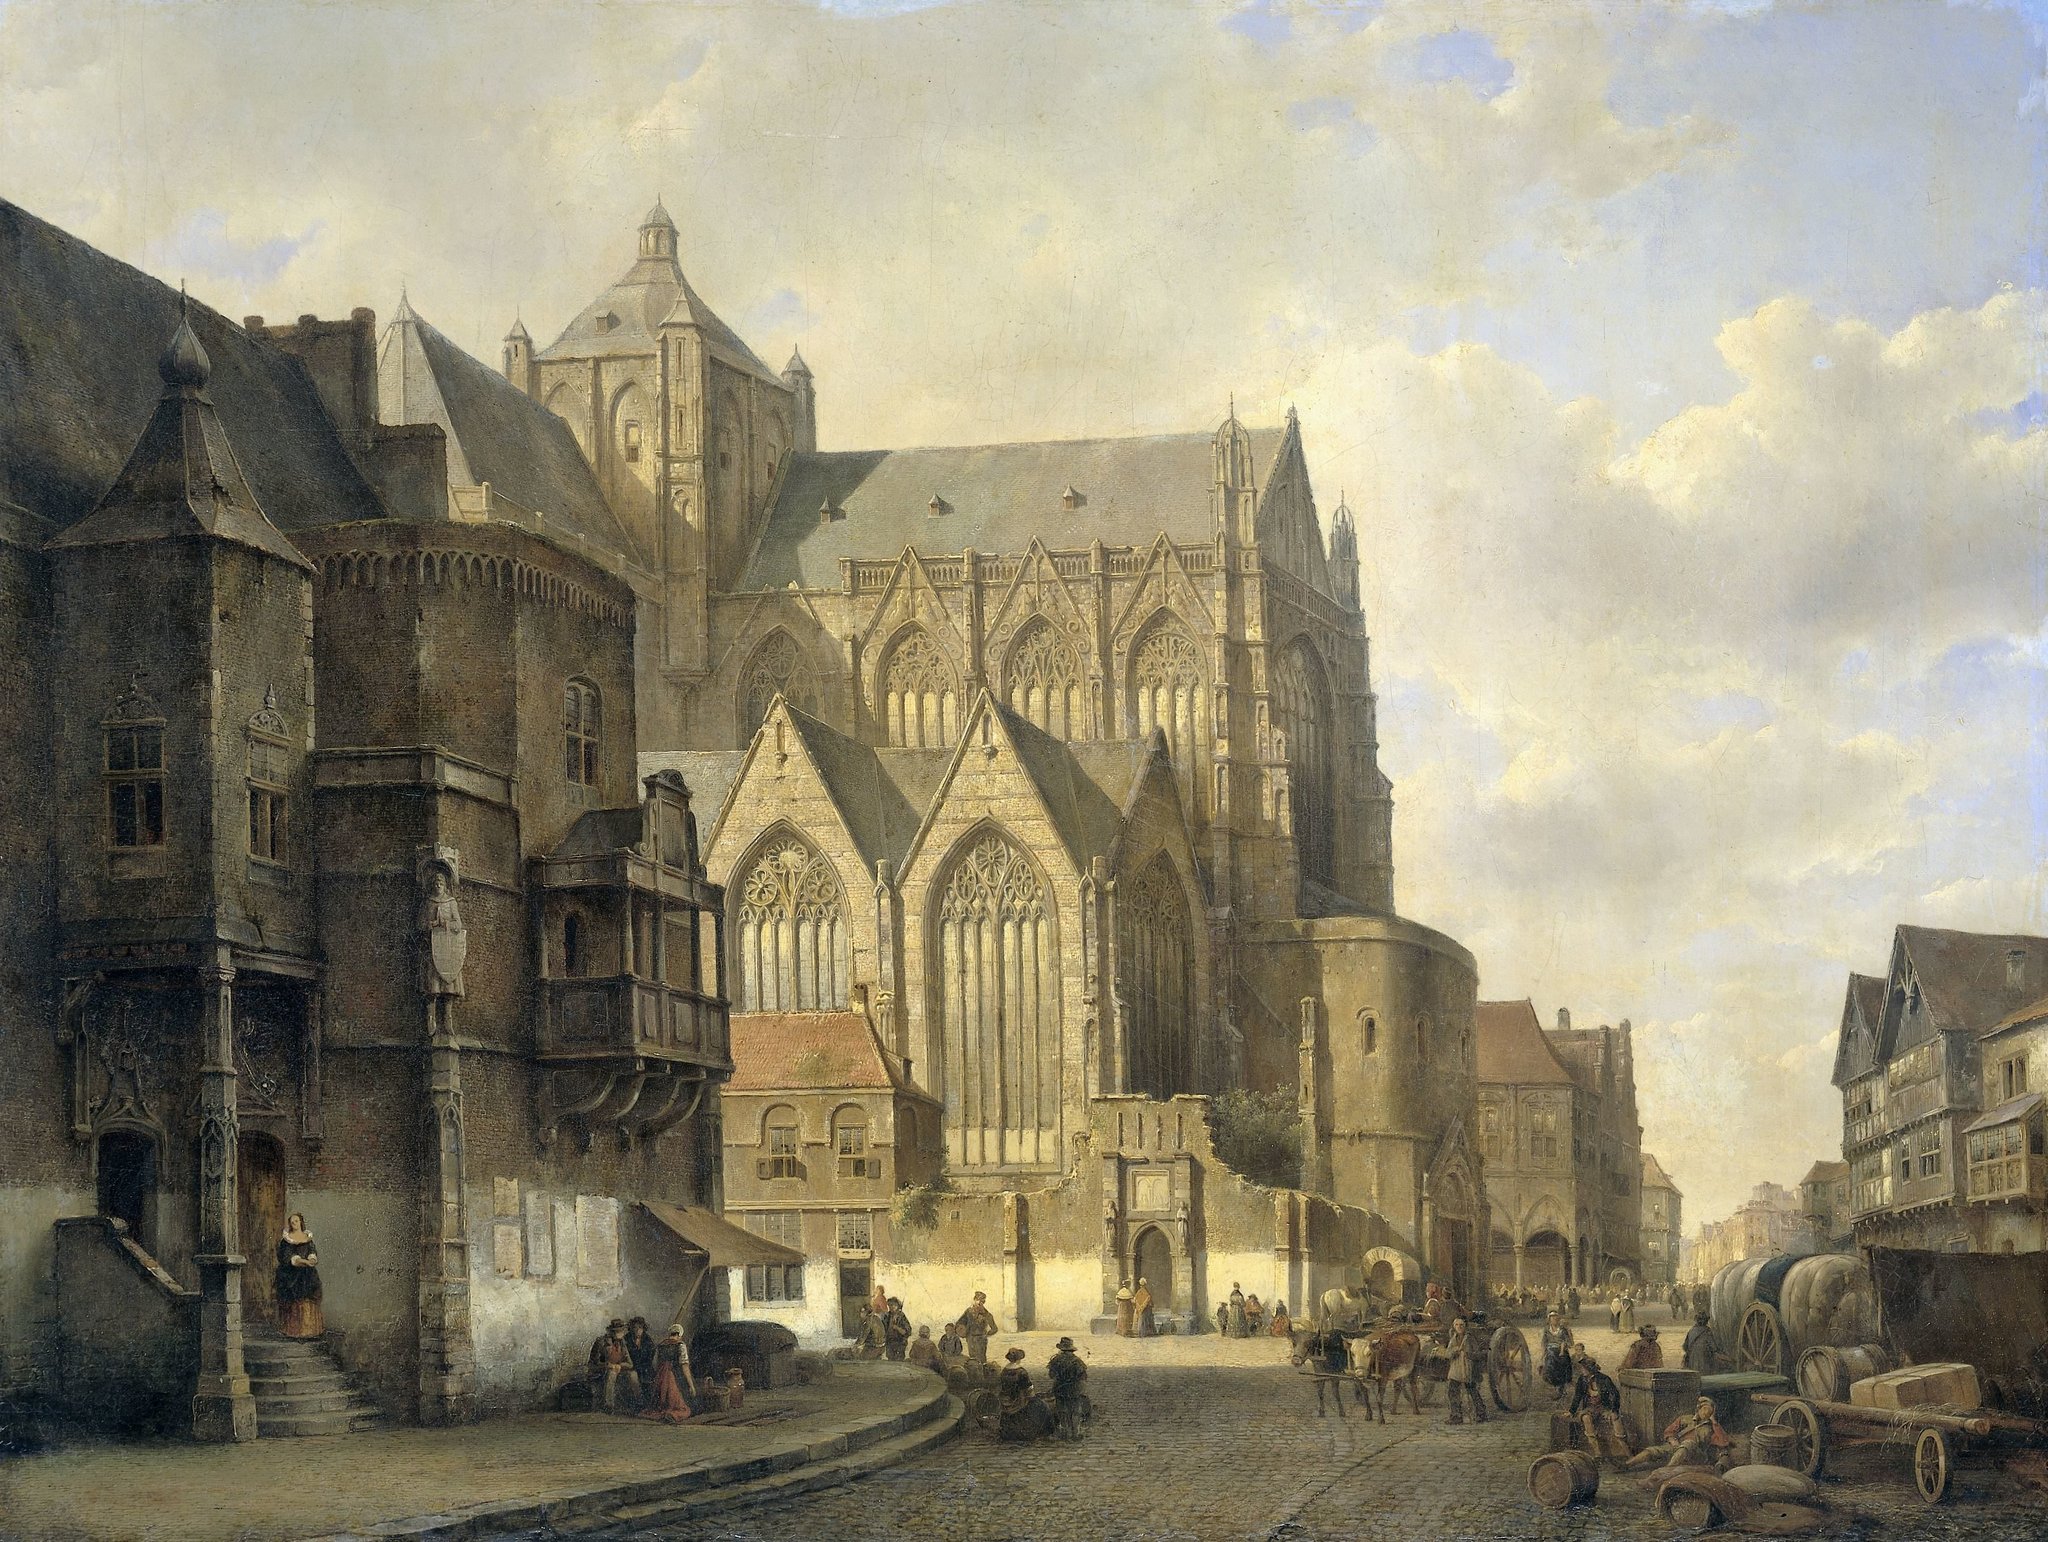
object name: painting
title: Townscape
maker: kasparus karsen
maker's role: draughtsman, painter, print maker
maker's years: 1810-1896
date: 1840-1880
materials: canvas, oil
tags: church (exterior), street (+ city(-scape) with figures, staffage)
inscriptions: signature: ‘K. Karsen’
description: Even though you might think this looks like a real place, it is not. Karsen was a master of imaginary townscapes, a genre in the Romantic era that was particularly popular around 1850. He travelled to Germany and Prague, and the sights along the way provided enough working material for the remainder of his life. This painting was given to the museum by his son Eduard, who was also a famous painter.